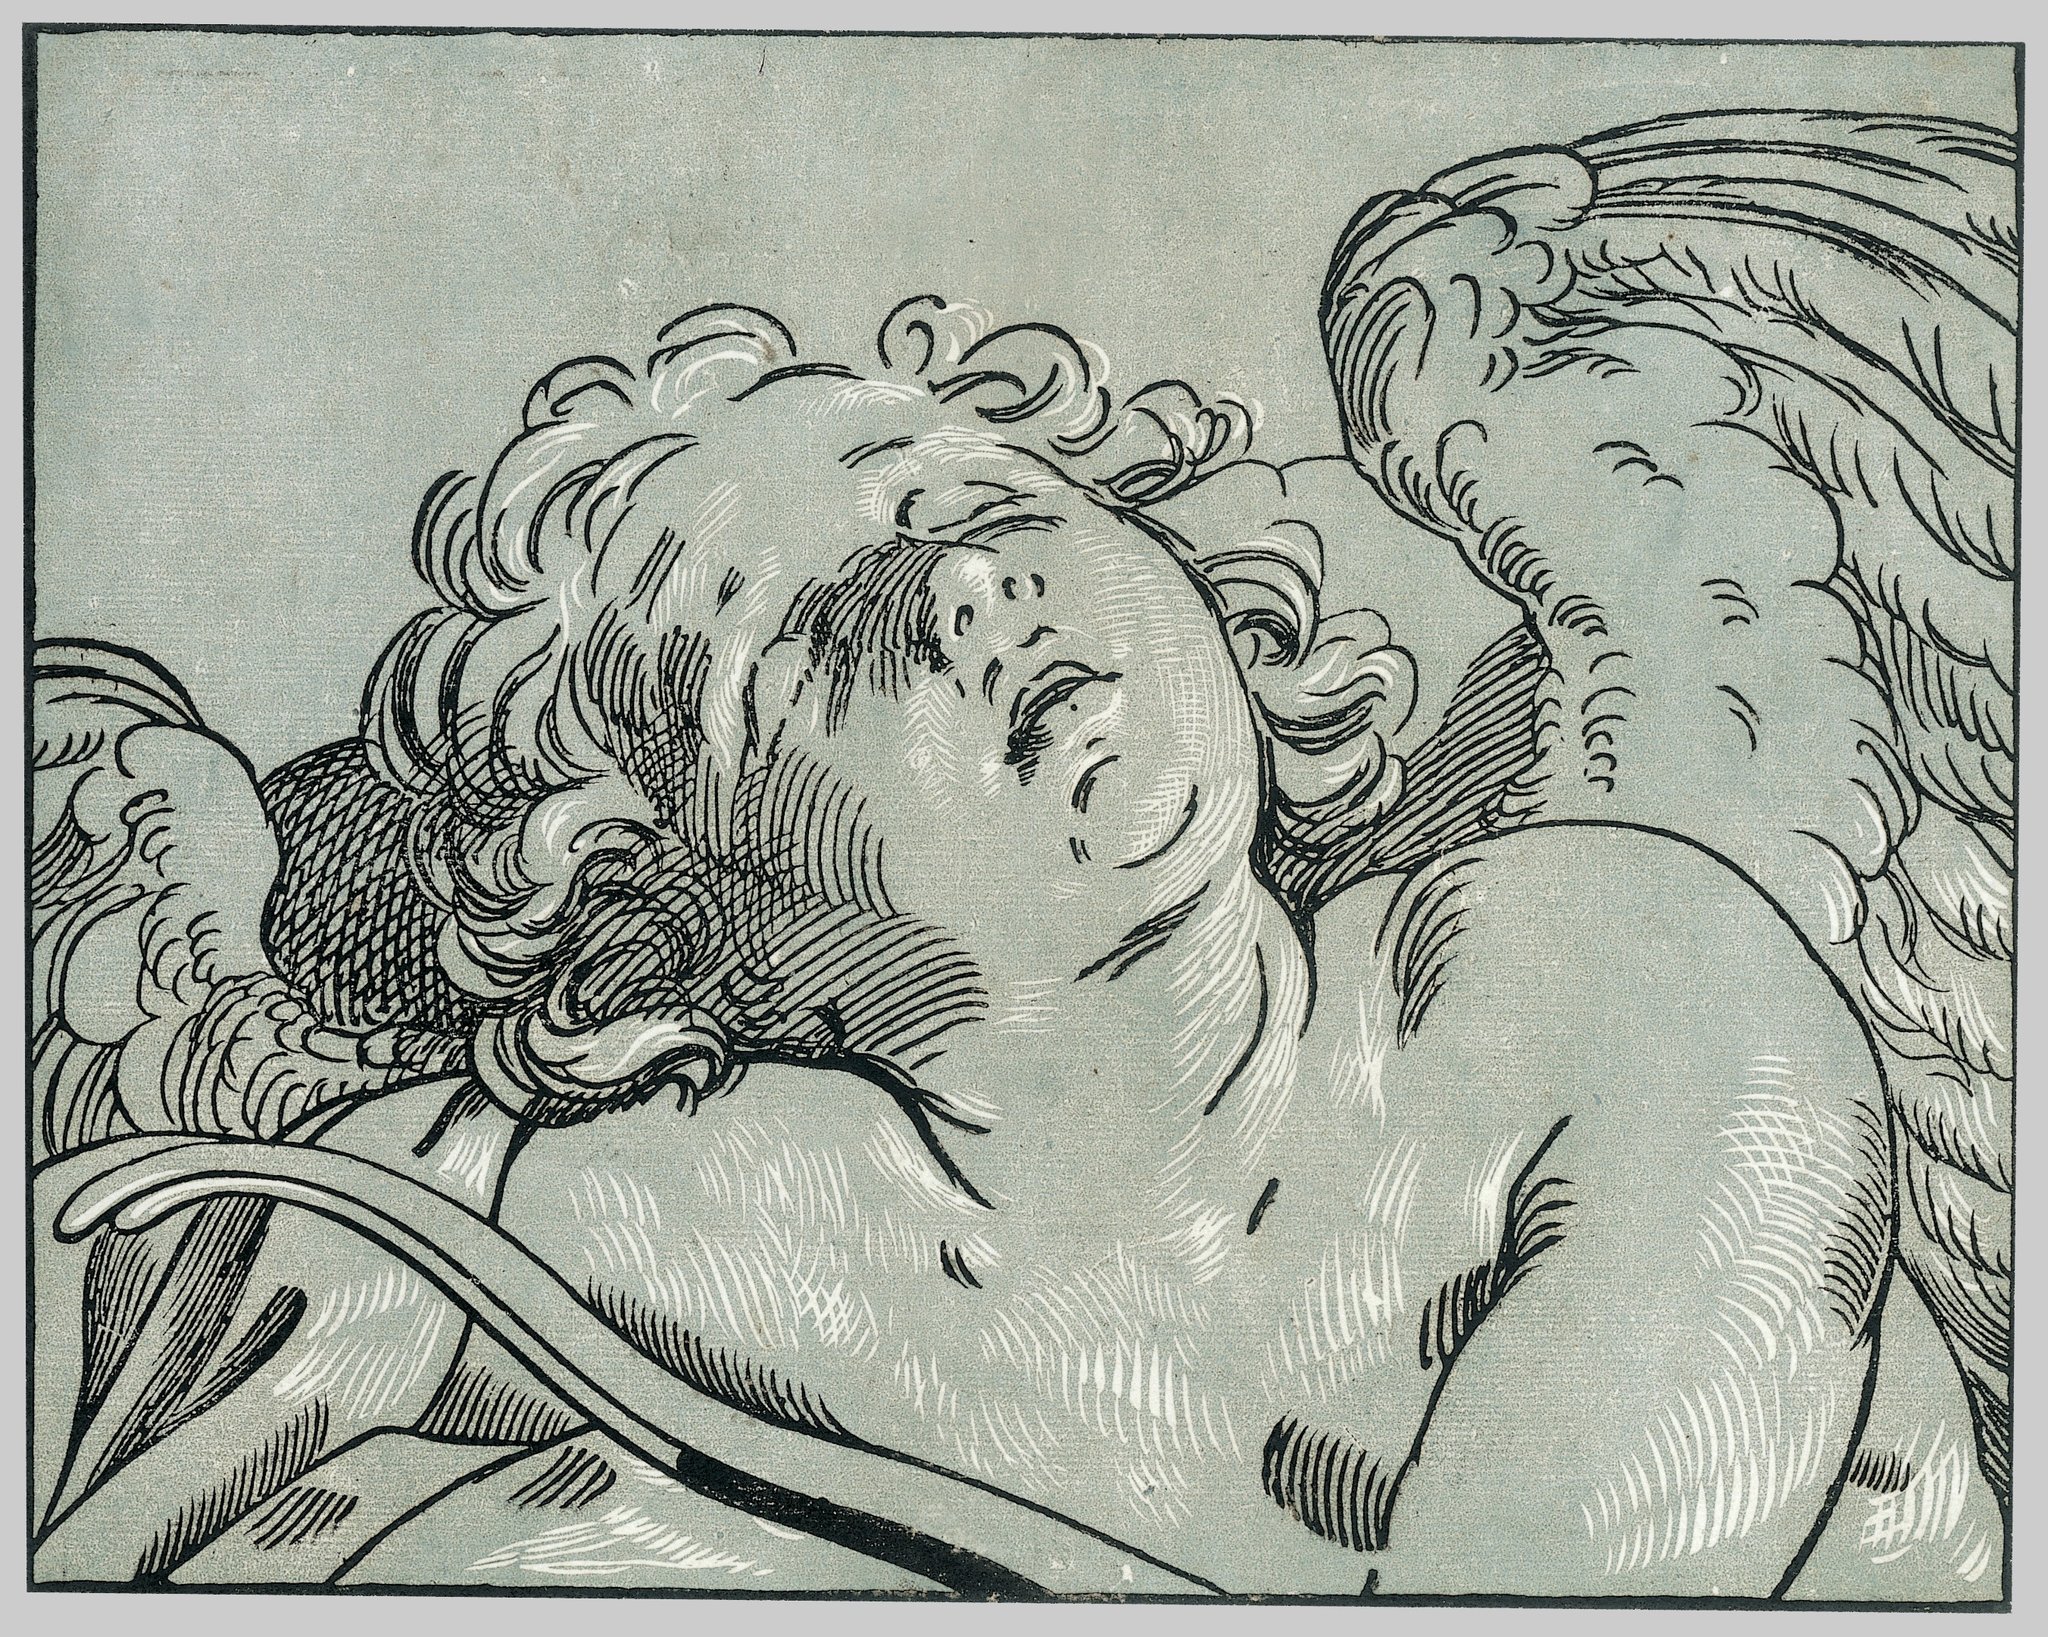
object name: print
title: A sleeping cupid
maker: bartolomeo coriolano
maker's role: artist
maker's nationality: italian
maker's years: 1599-1676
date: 1630-1645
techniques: woodcut, printing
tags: sleeping,cupid